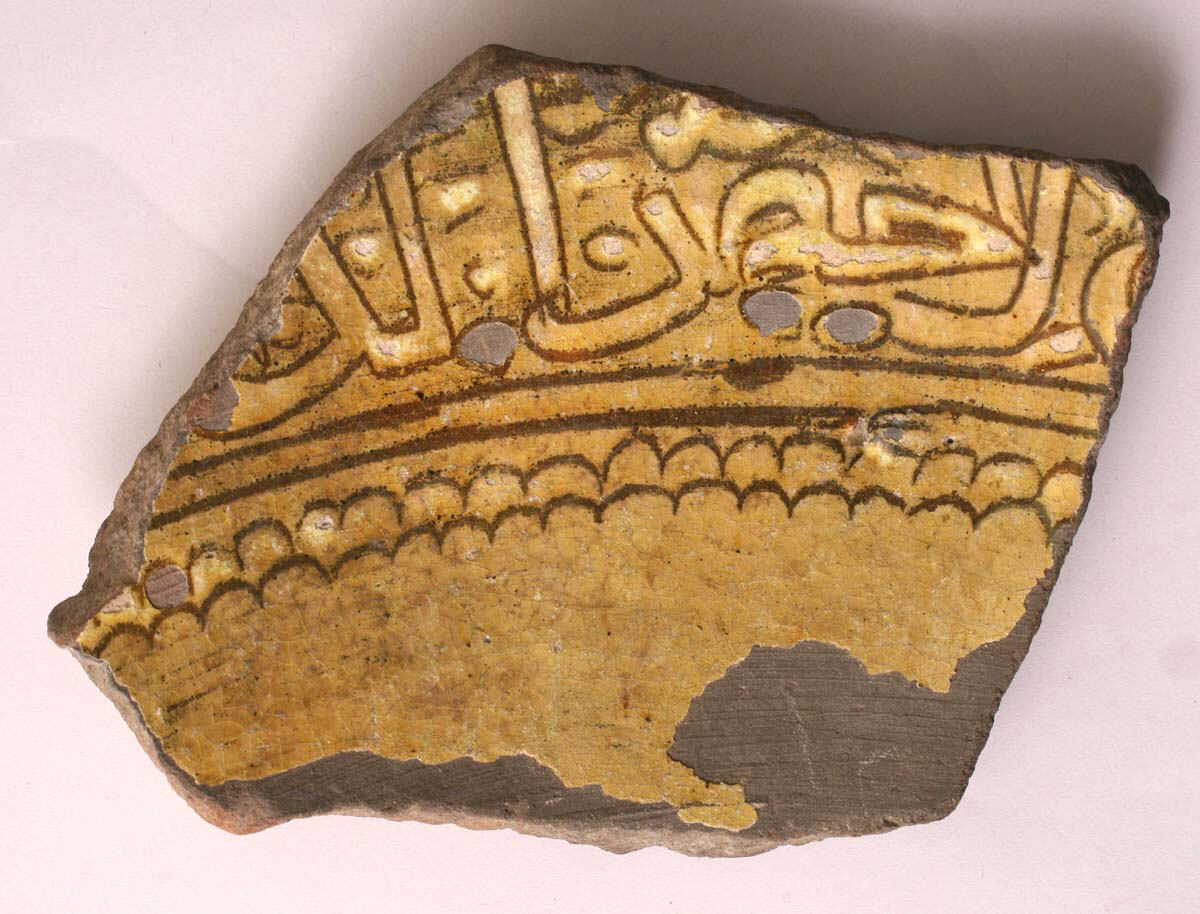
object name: fragment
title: Ceramic Fragment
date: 1301-1500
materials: earthenware, glaze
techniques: coloring, incising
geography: egypt